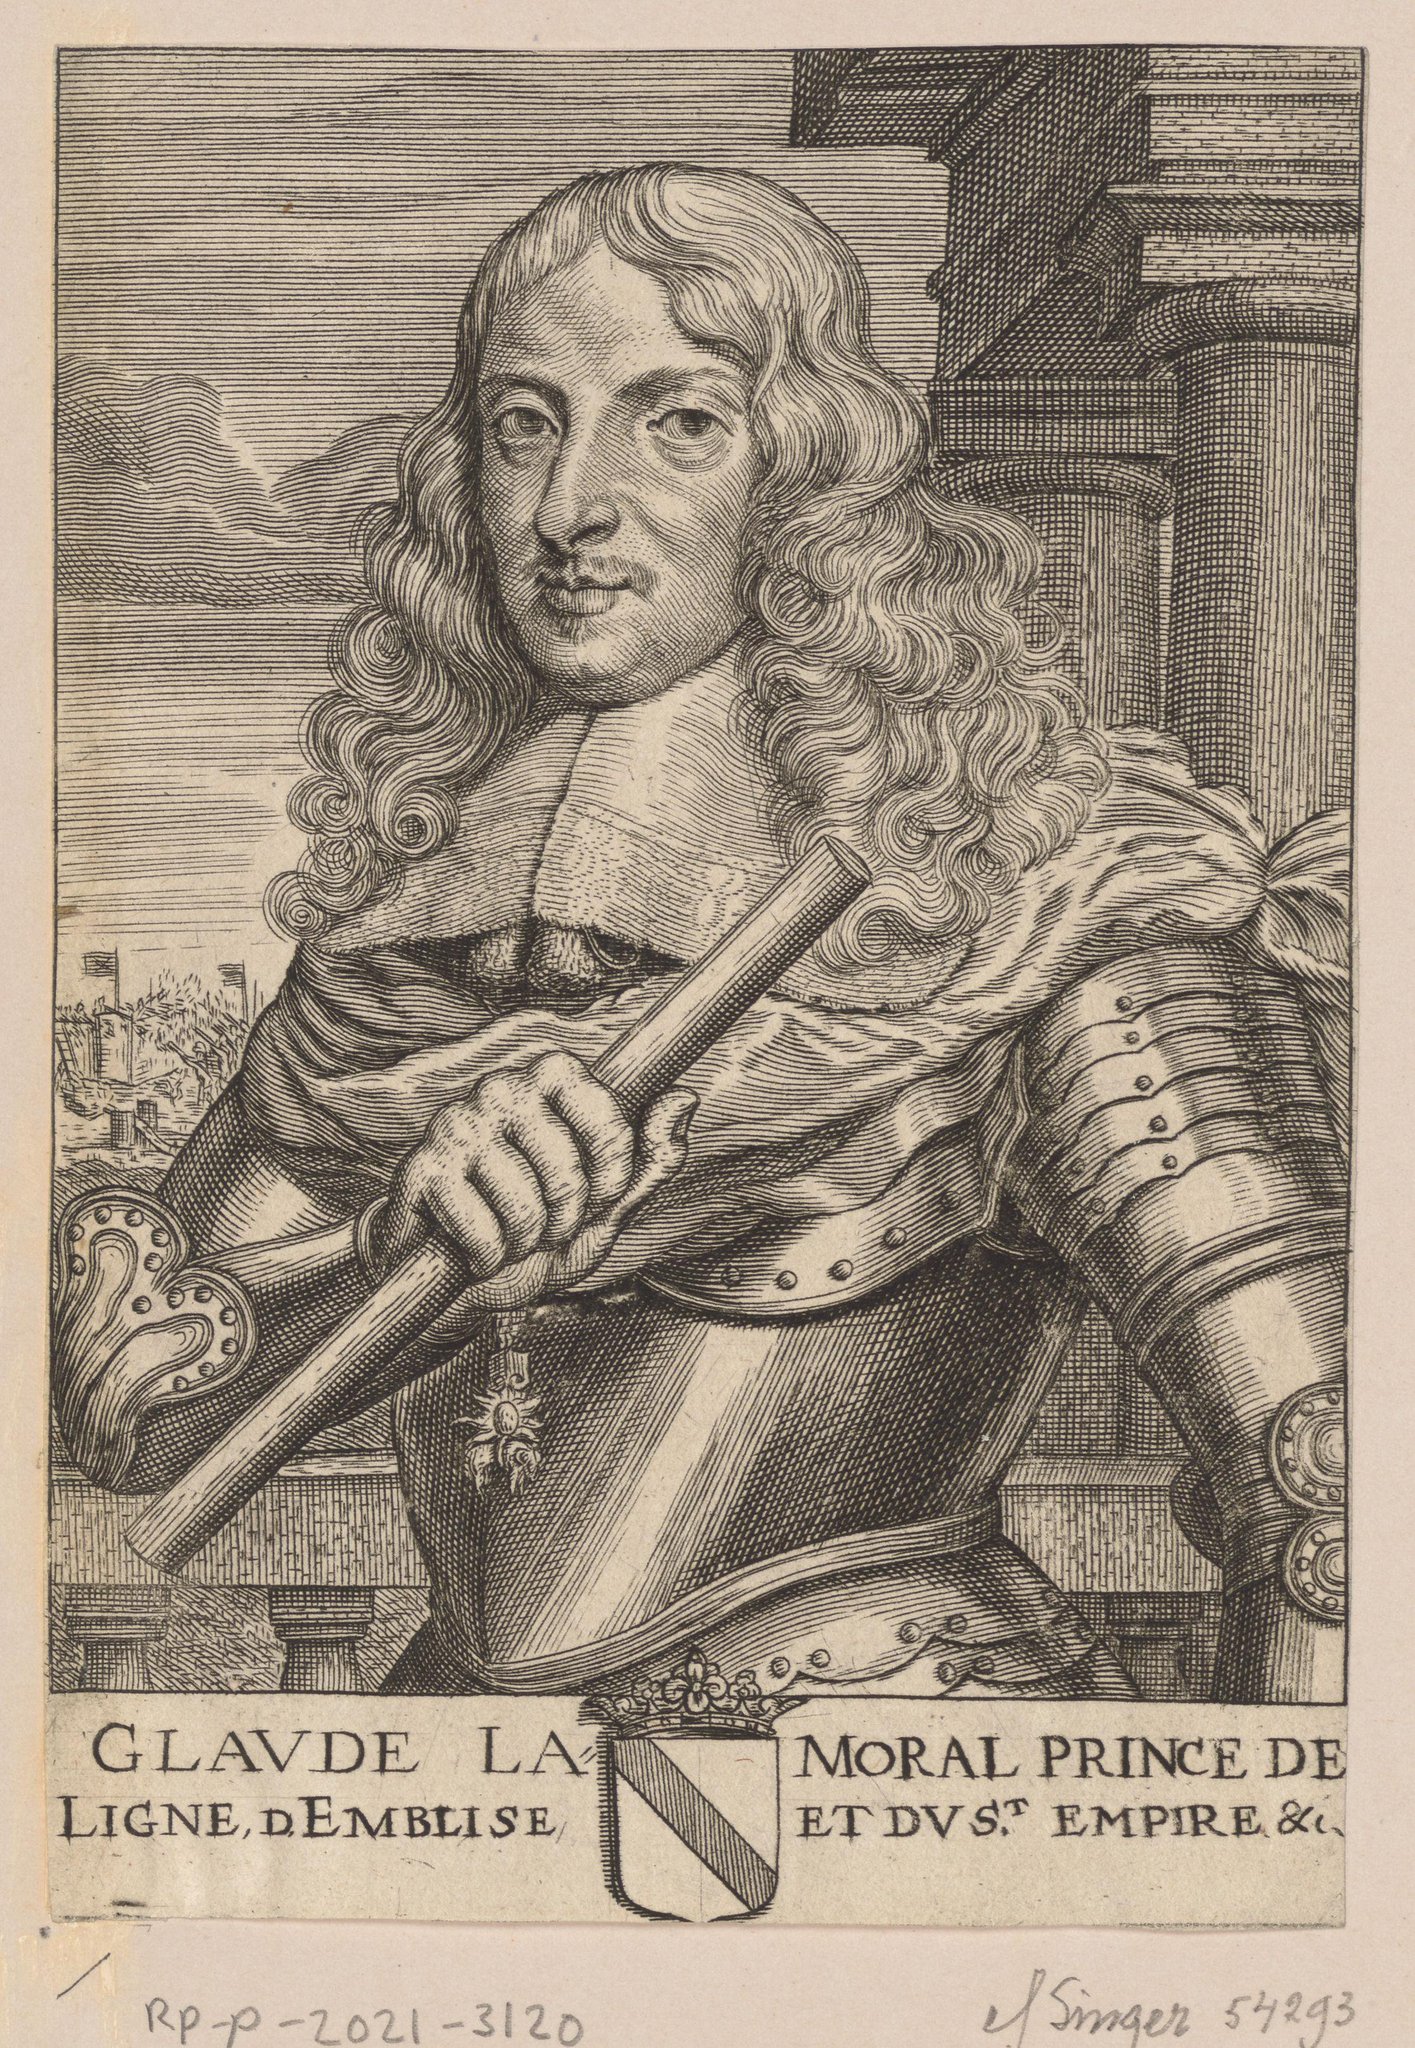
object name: print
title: Portret van Claude Lamoral I van Ligne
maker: Anonymous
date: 1641-1699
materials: paper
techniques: engraving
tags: armour, historical persons, battle, knighthood order of the golden fleece - insignia of a knighthood order, e.g.: badge, chain (with name of order), armorial bearing, heraldry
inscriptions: number: ‘N 19 839’